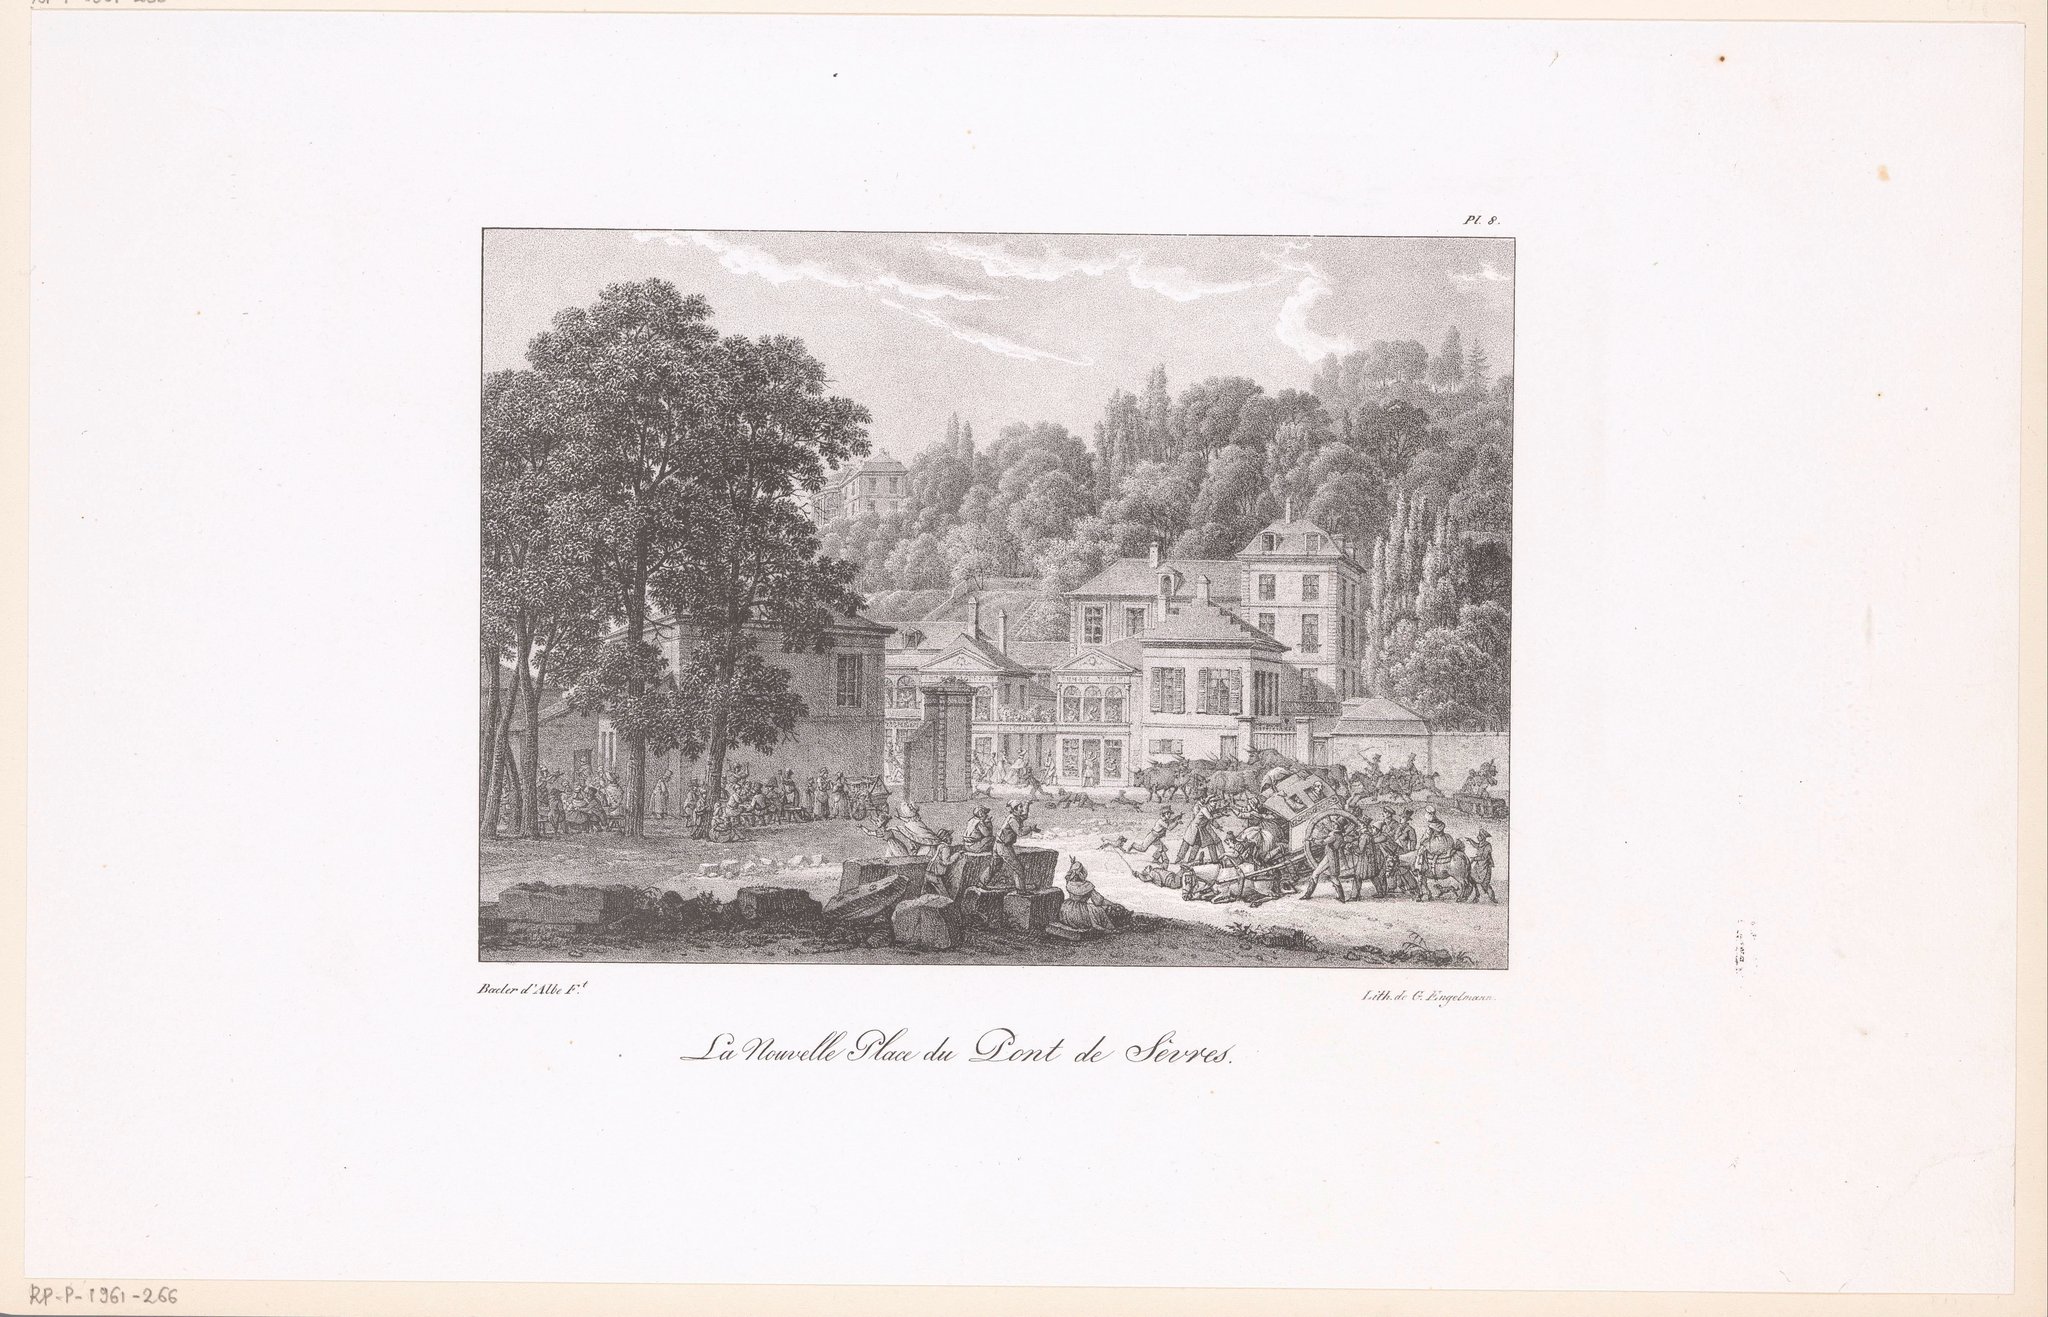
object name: print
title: Promenades pittoresques et lithographiques dans Paris et ses environs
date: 1822-1824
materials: paper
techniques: lithograph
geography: paris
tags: accident with animal-drawn vehicle, village square, place (+ city(-scape) with figures, staffage)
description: Op de voorgrond is een koets omgevallen. Op de achtergrond wordt een man opgejaagd door een groep stieren.